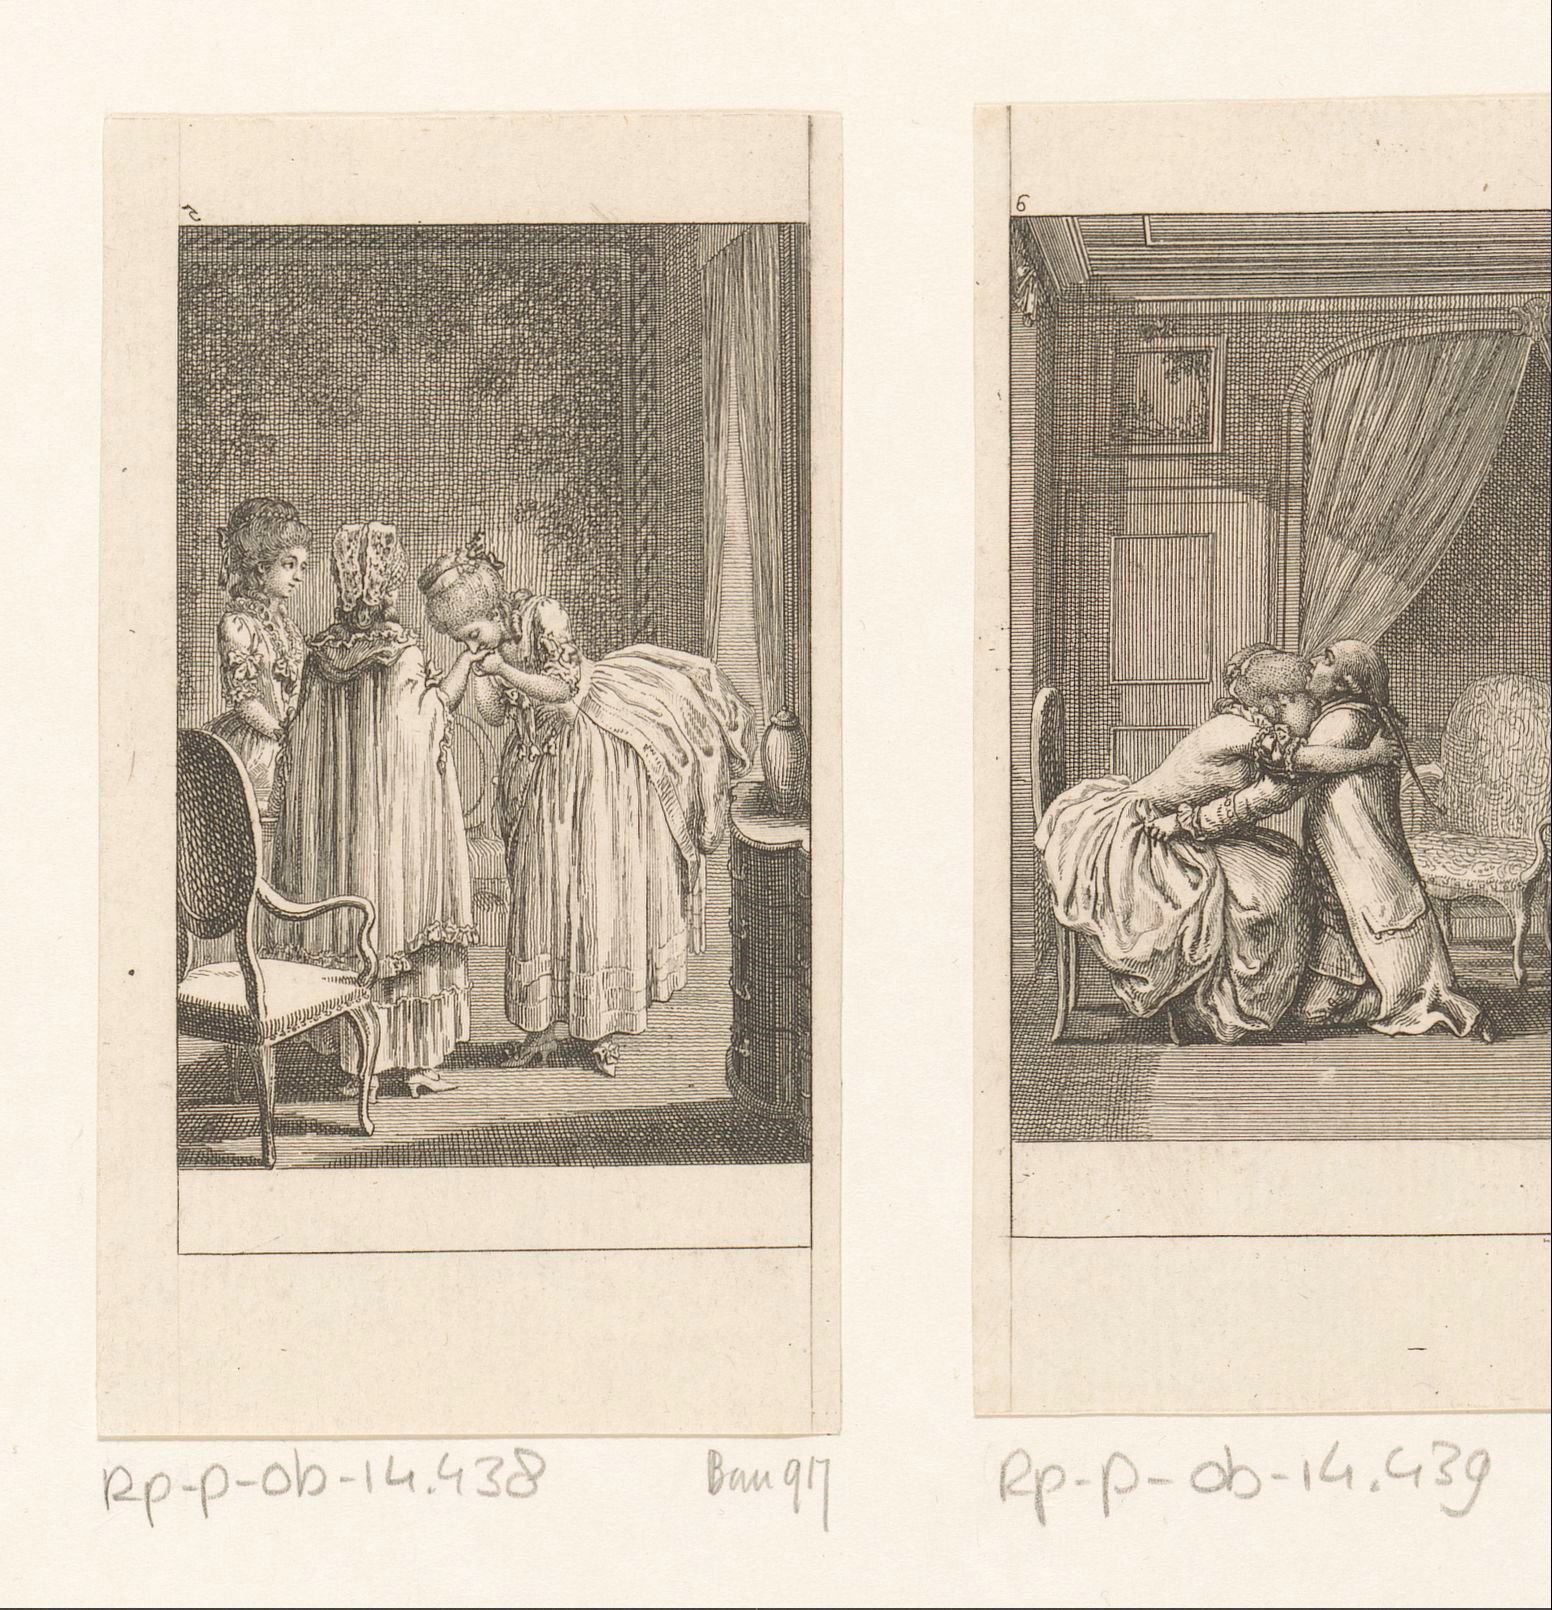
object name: print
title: Julie op bezoek bij Frau von Étange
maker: daniel nikolaus chodowiecki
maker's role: draughtsman, print maker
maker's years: 1726-1801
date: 1782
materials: paper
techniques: etching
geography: berlin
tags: visiting; receiving guests; elegant company, meeting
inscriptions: collector's mark: Lugt 2228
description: Vervaardigd voor Jean-Jacques Rousseaus 'Neue Héliose'. Latere staat gebruikt voor: Almanac généalogique pour l'année 1783. Berlijn: s.n., 1782.